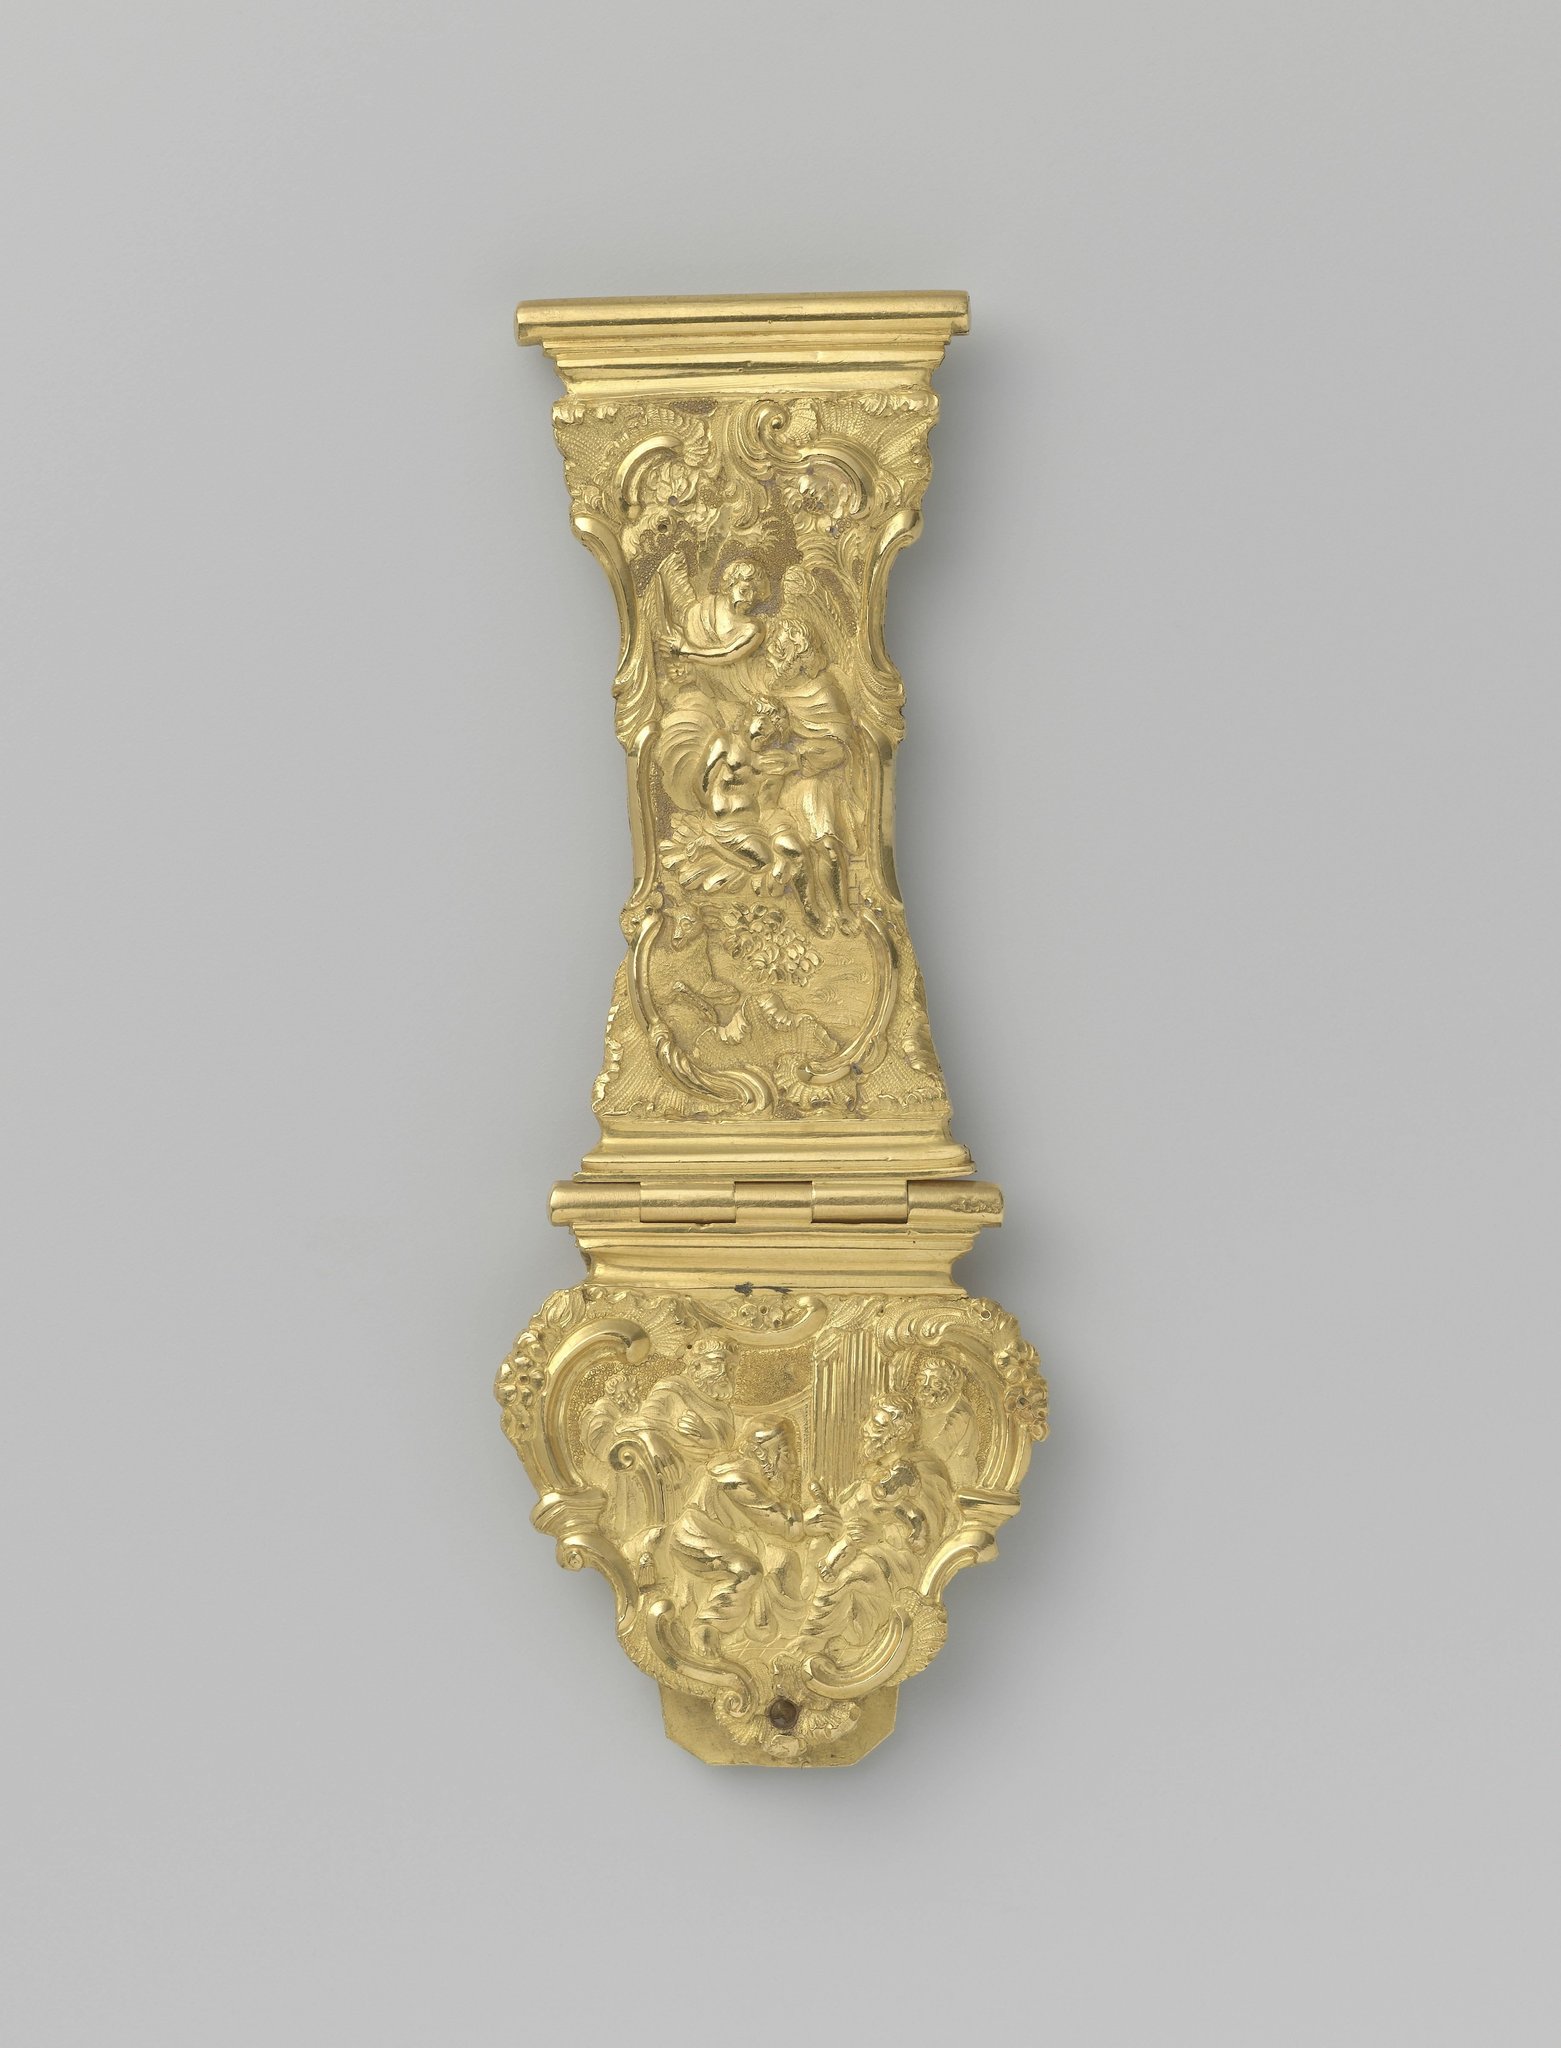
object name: boekslot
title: Beugel van een boekslot met voorstellingen van het offer van Abraham en de besnijdenis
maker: Anonymous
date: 1773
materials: gold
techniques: casting, metalworking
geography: the hague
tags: the sacrifice of isaac (genesis 22), circumcision of the christ-child by the priest in the temple (luke 2:21)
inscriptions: date letter: ‘B’, alloy mark, maker's mark, town mark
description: Book clasps. Gold. The Hague, 1773, maker's mark a lily. Watch. Gold. Amsterdam, c. 1740. F.G.S. baron van Brakell tot den Brakell bequest.